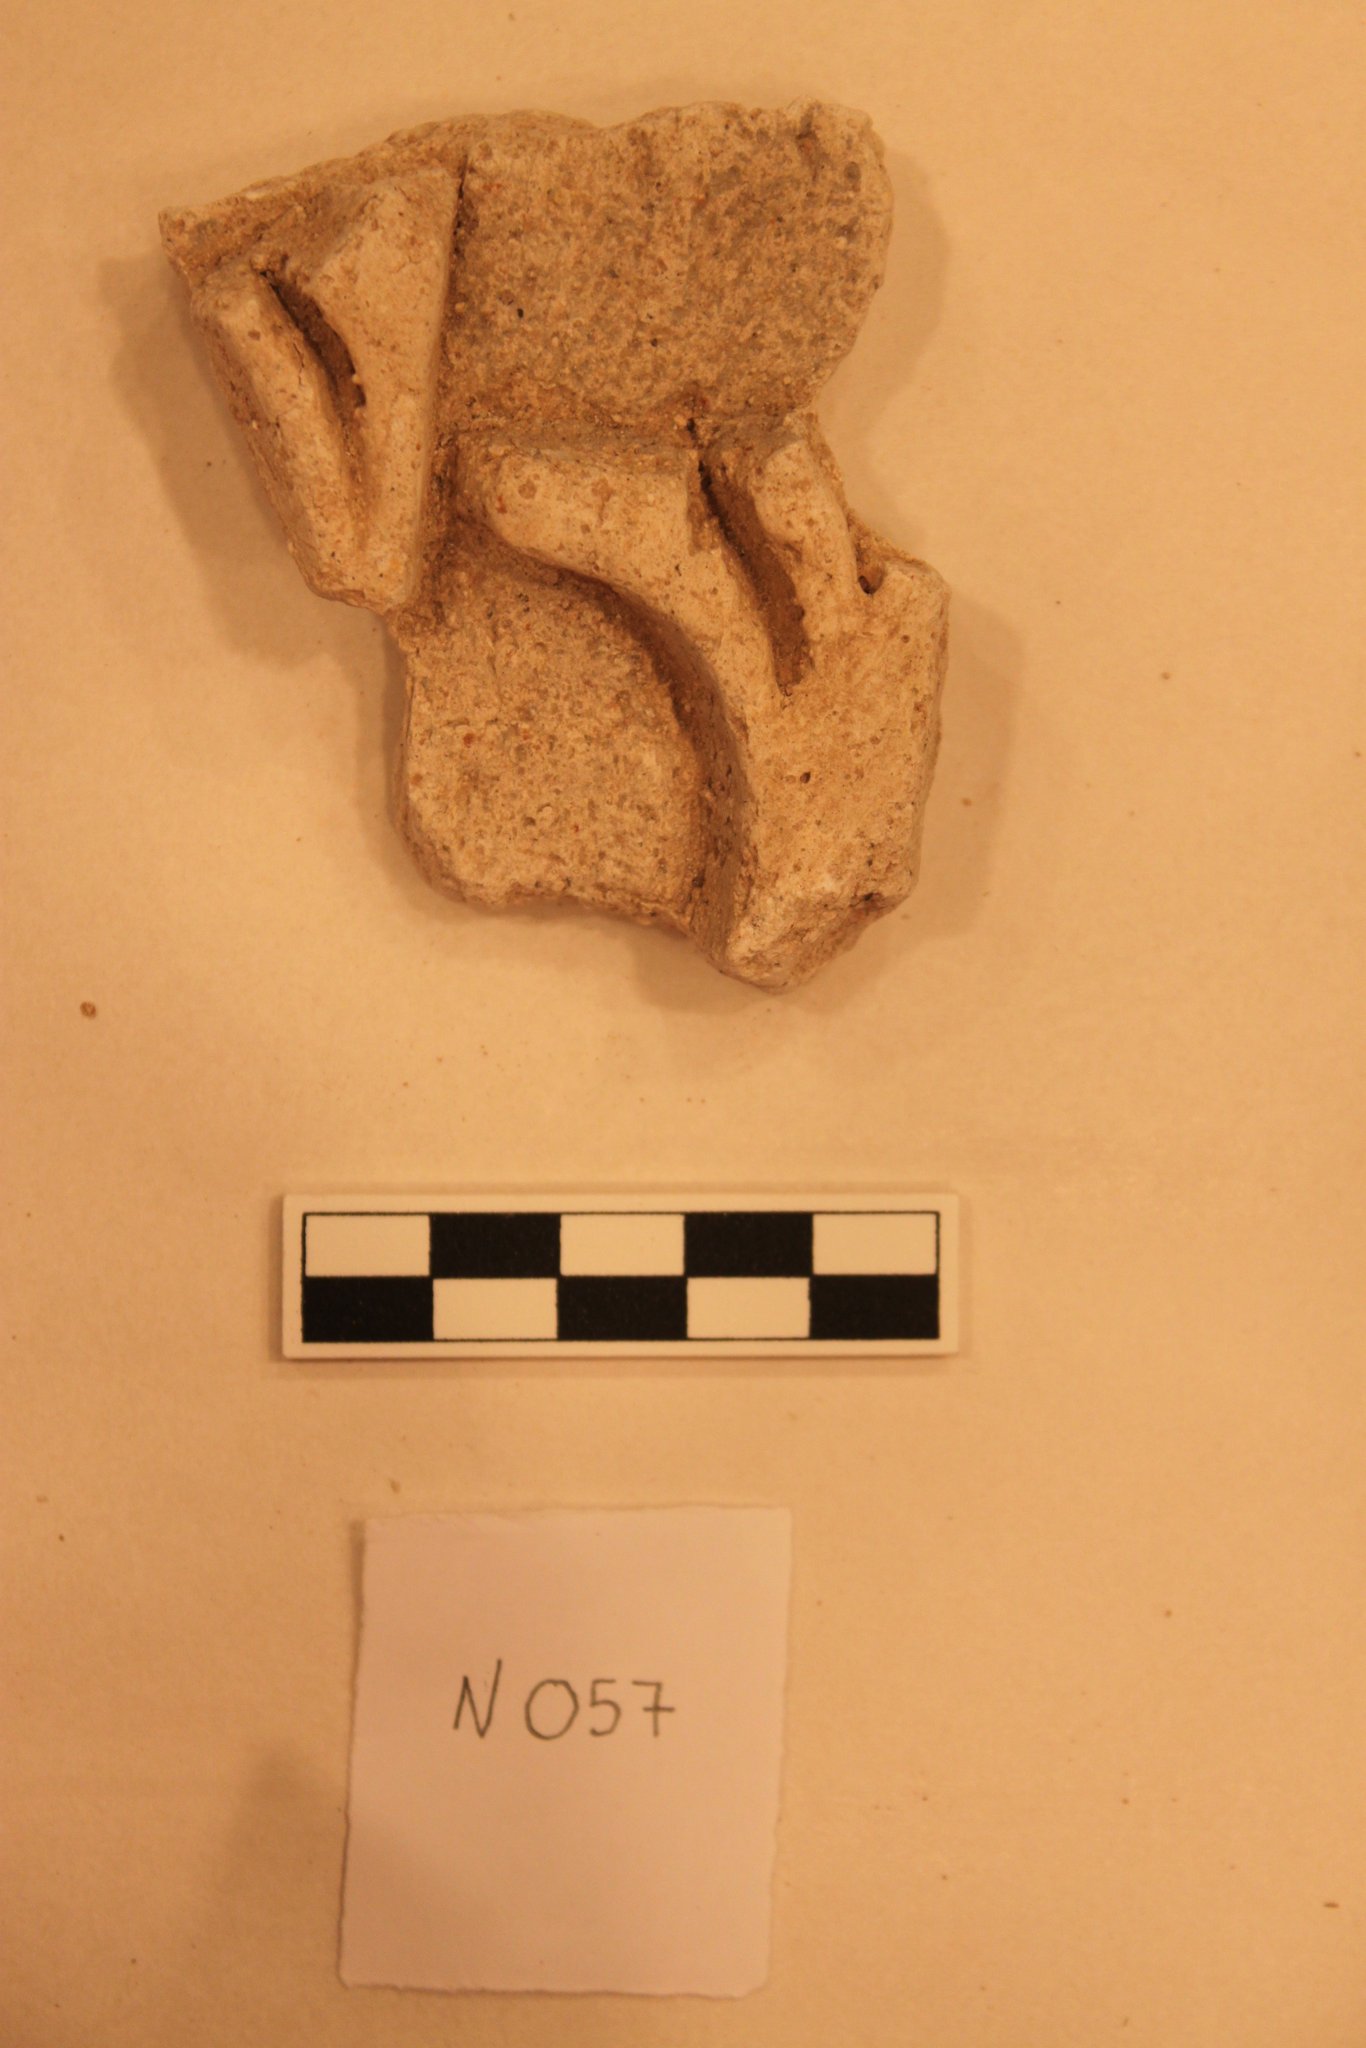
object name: fragment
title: Stucco Fragment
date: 701-1200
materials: plaster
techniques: carving, painting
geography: iran